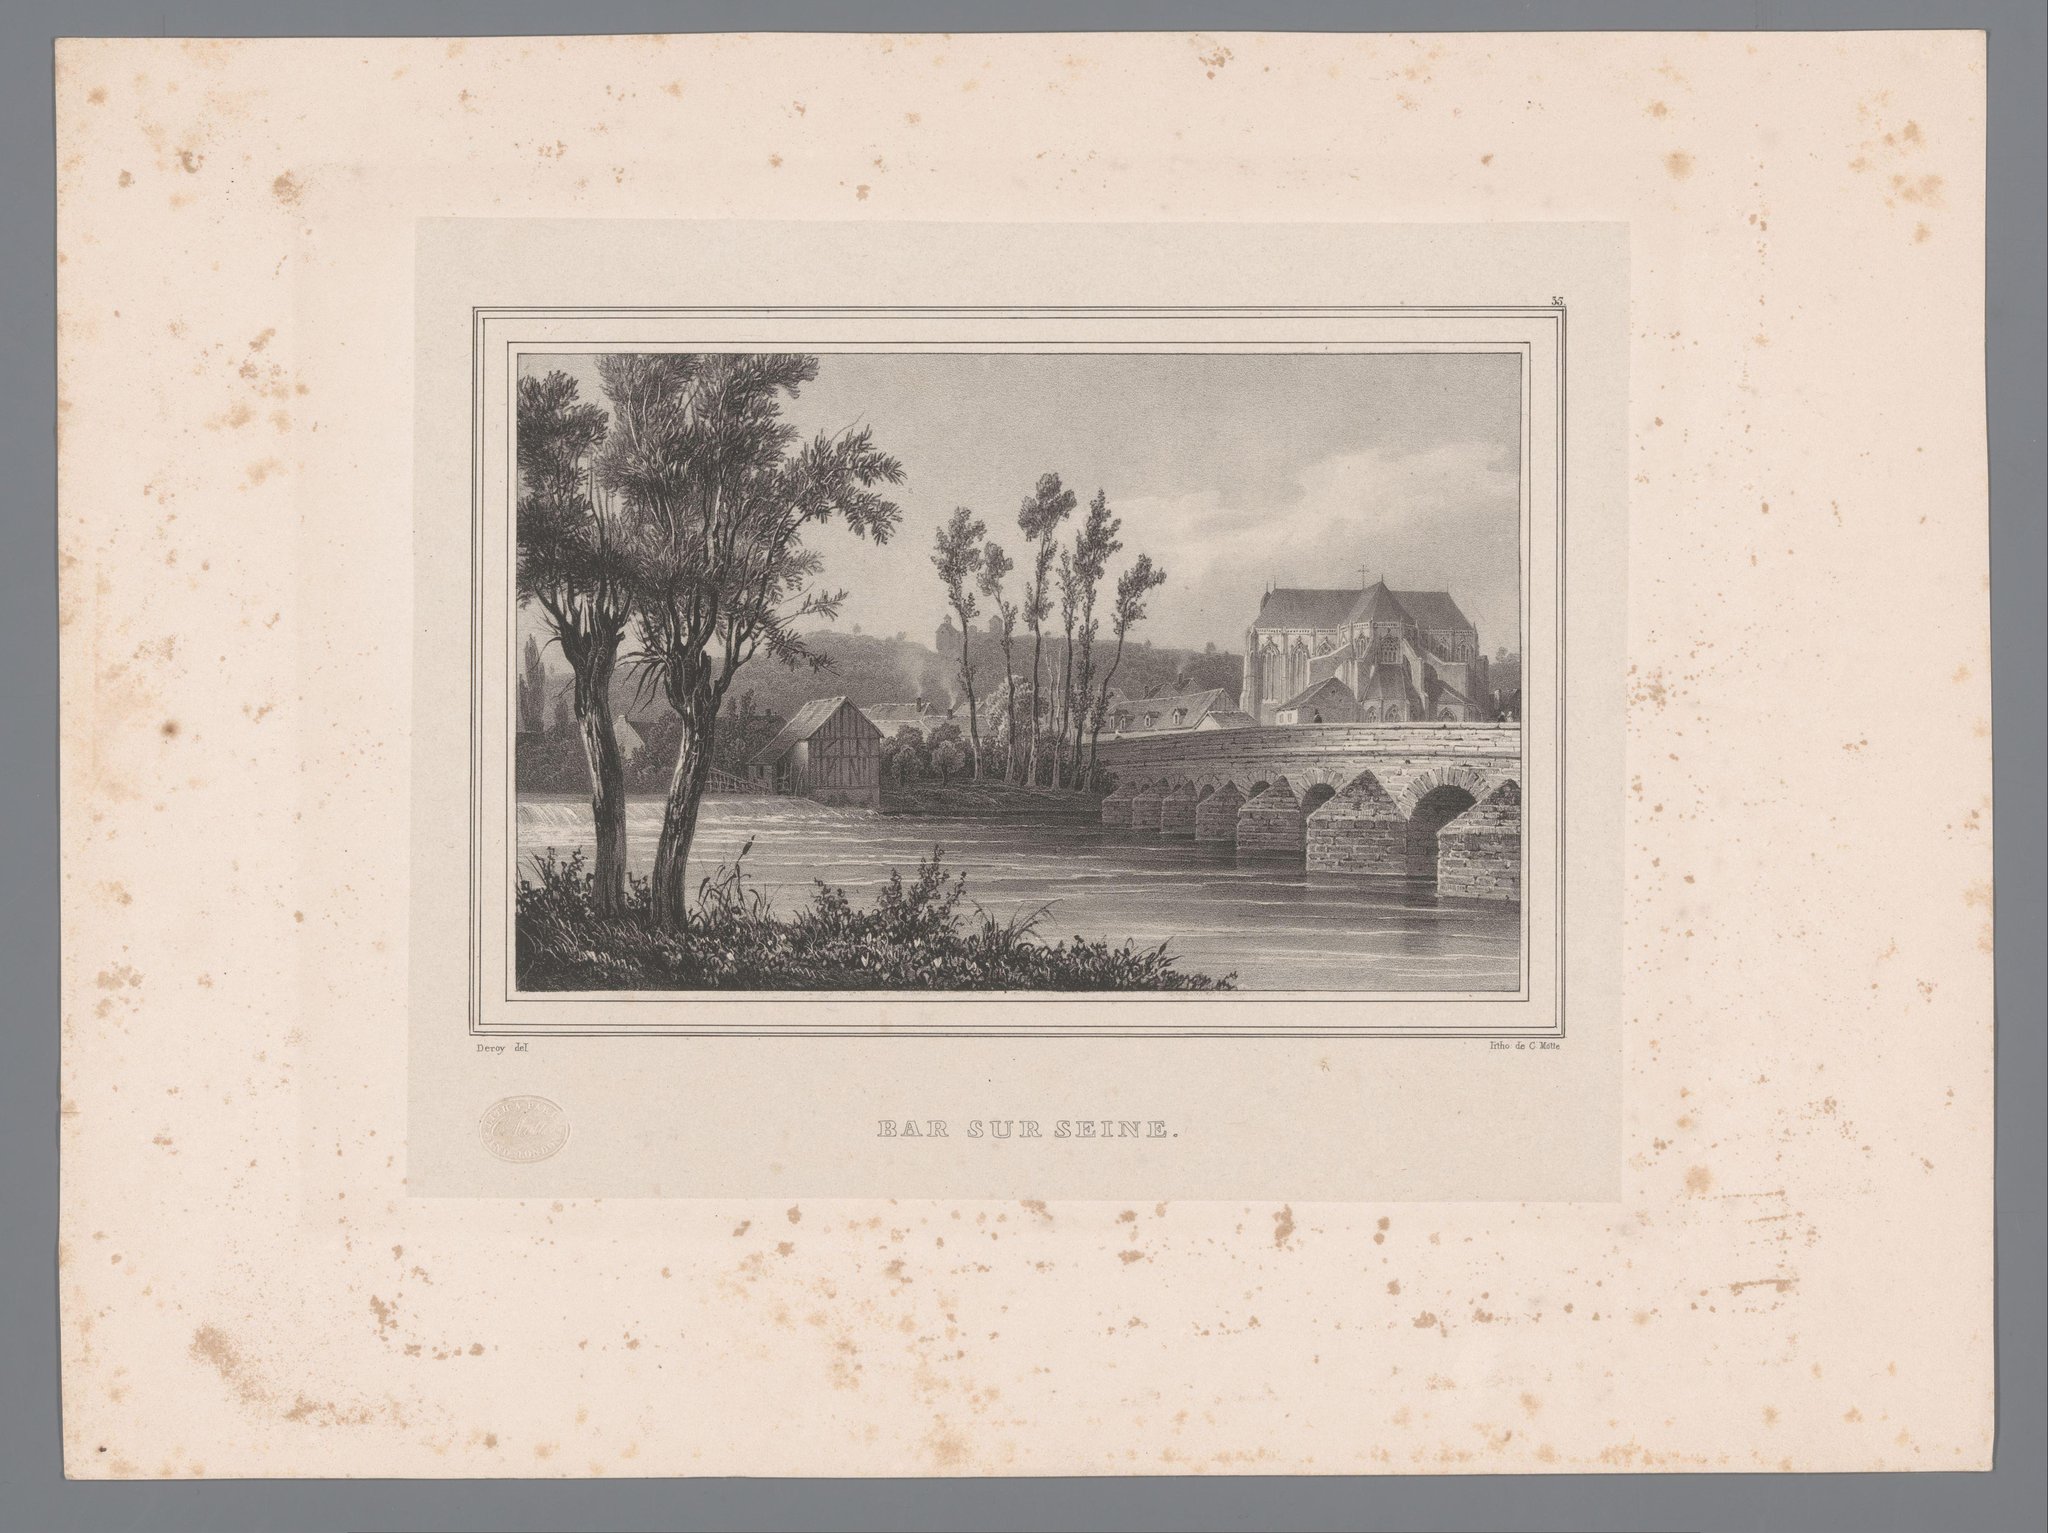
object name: print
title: Zicht op Bar-sur-Seine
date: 1829-1831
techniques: printmaking, lithograph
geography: bar-sur-seine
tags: bridge in city across river, canal, etc., river (+ landscape with figures, staffage), prospect of city, town panorama, silhouette of city (+ city(-scape) with figures, staffage)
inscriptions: collector's mark: Lugt 2228a, check stamp: Lugt 1828b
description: Prent maakt deel uit van een omslag met dertien prenten.